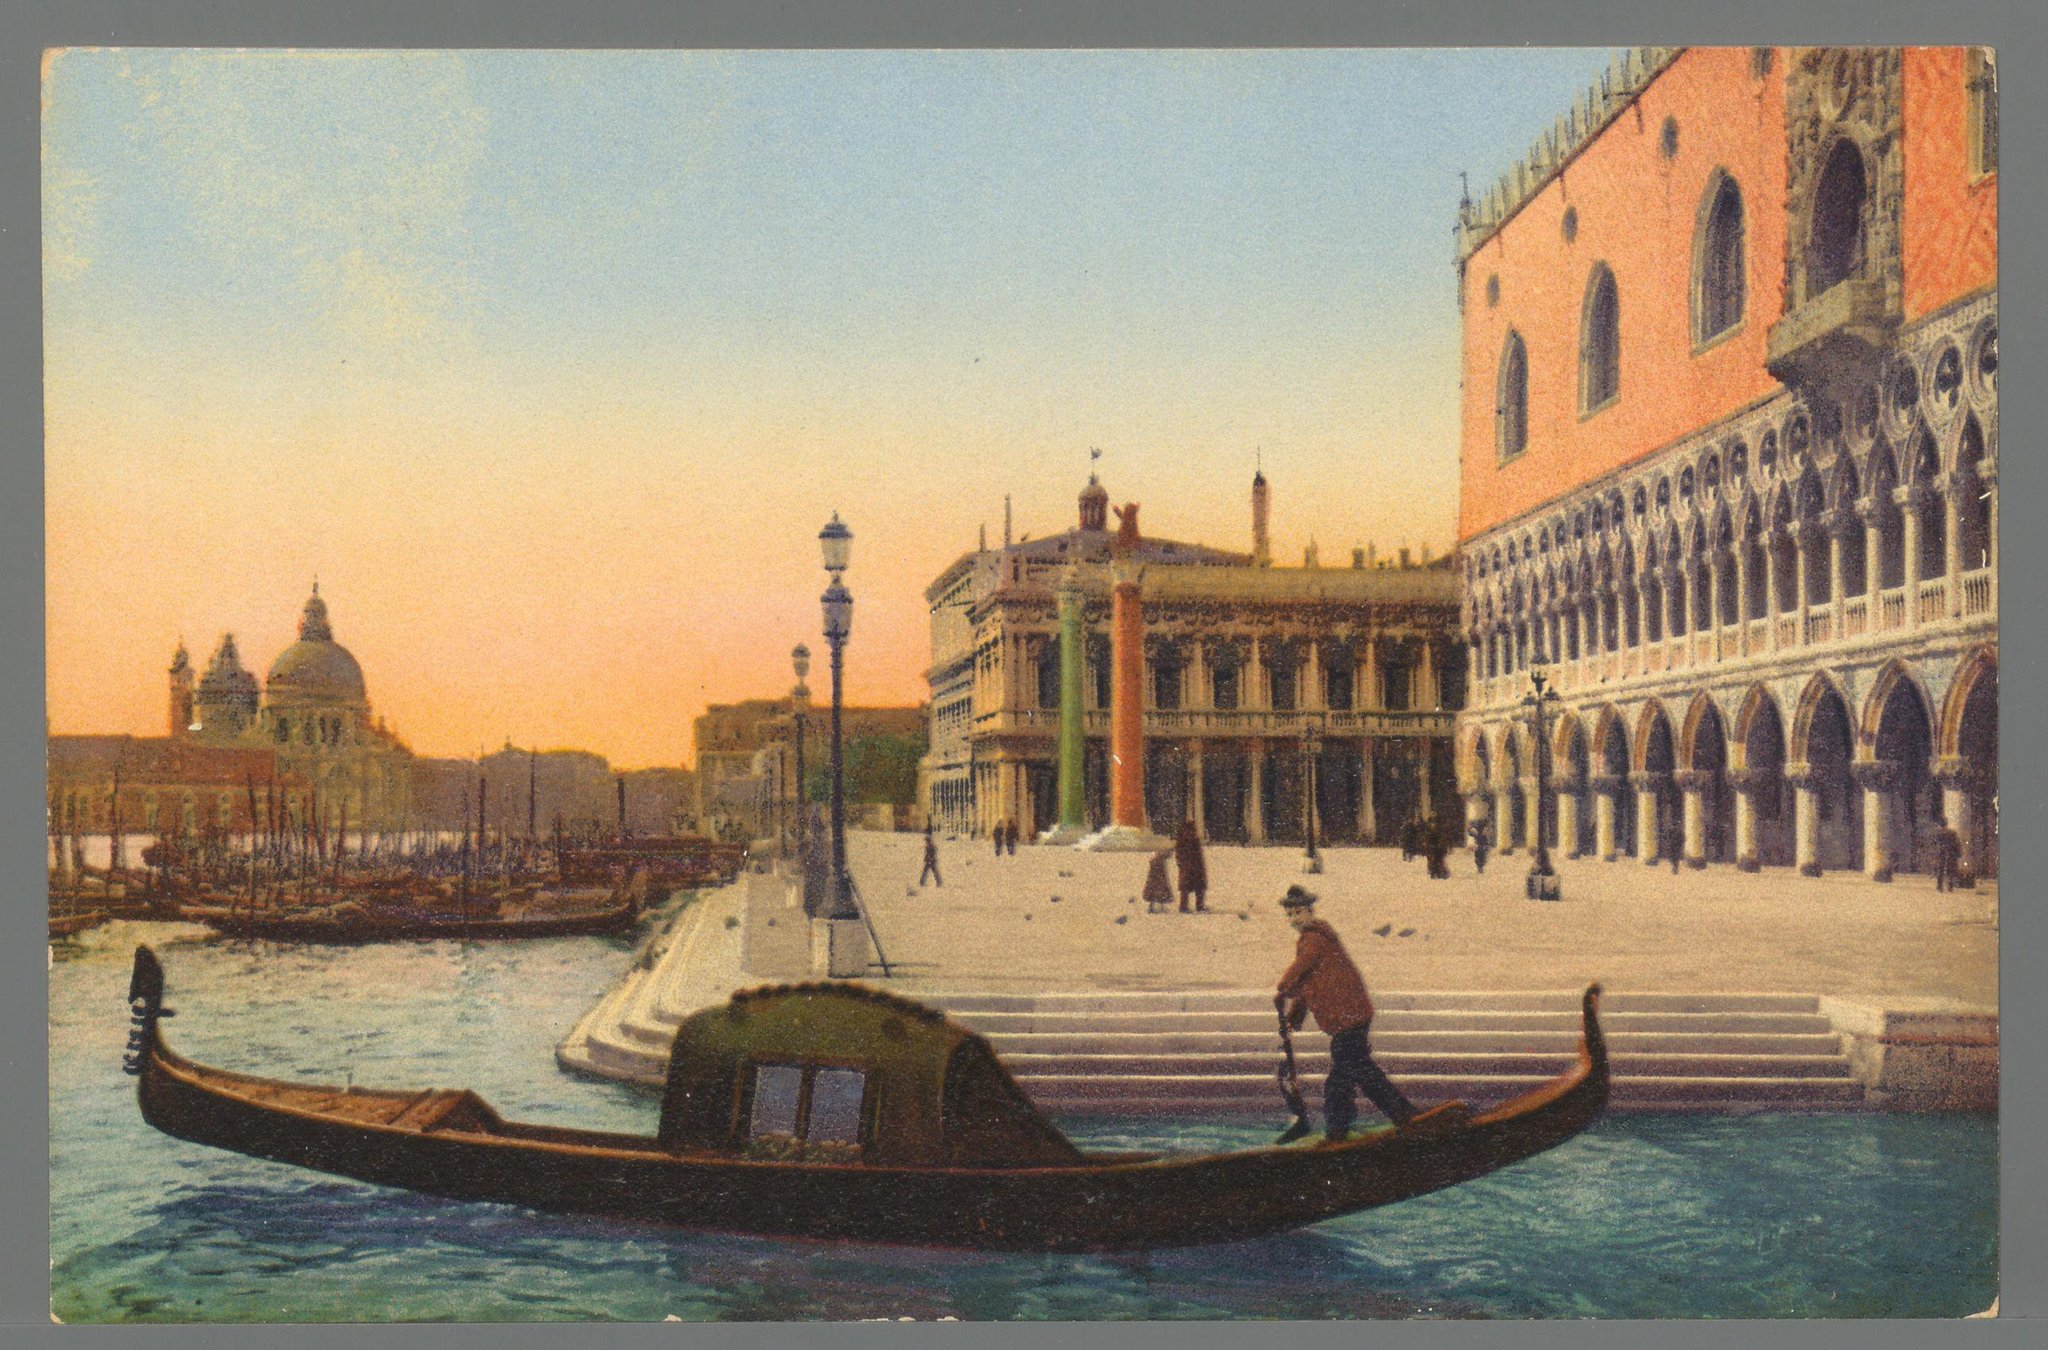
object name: ansichtkaart, prentbriefkaart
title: Venezia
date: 1903-1925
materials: cardboard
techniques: lithograph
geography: zurich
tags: palace, gondola, city-view, and landscape with man-made constructions (+ city(-scape) with figures, staffage), venice